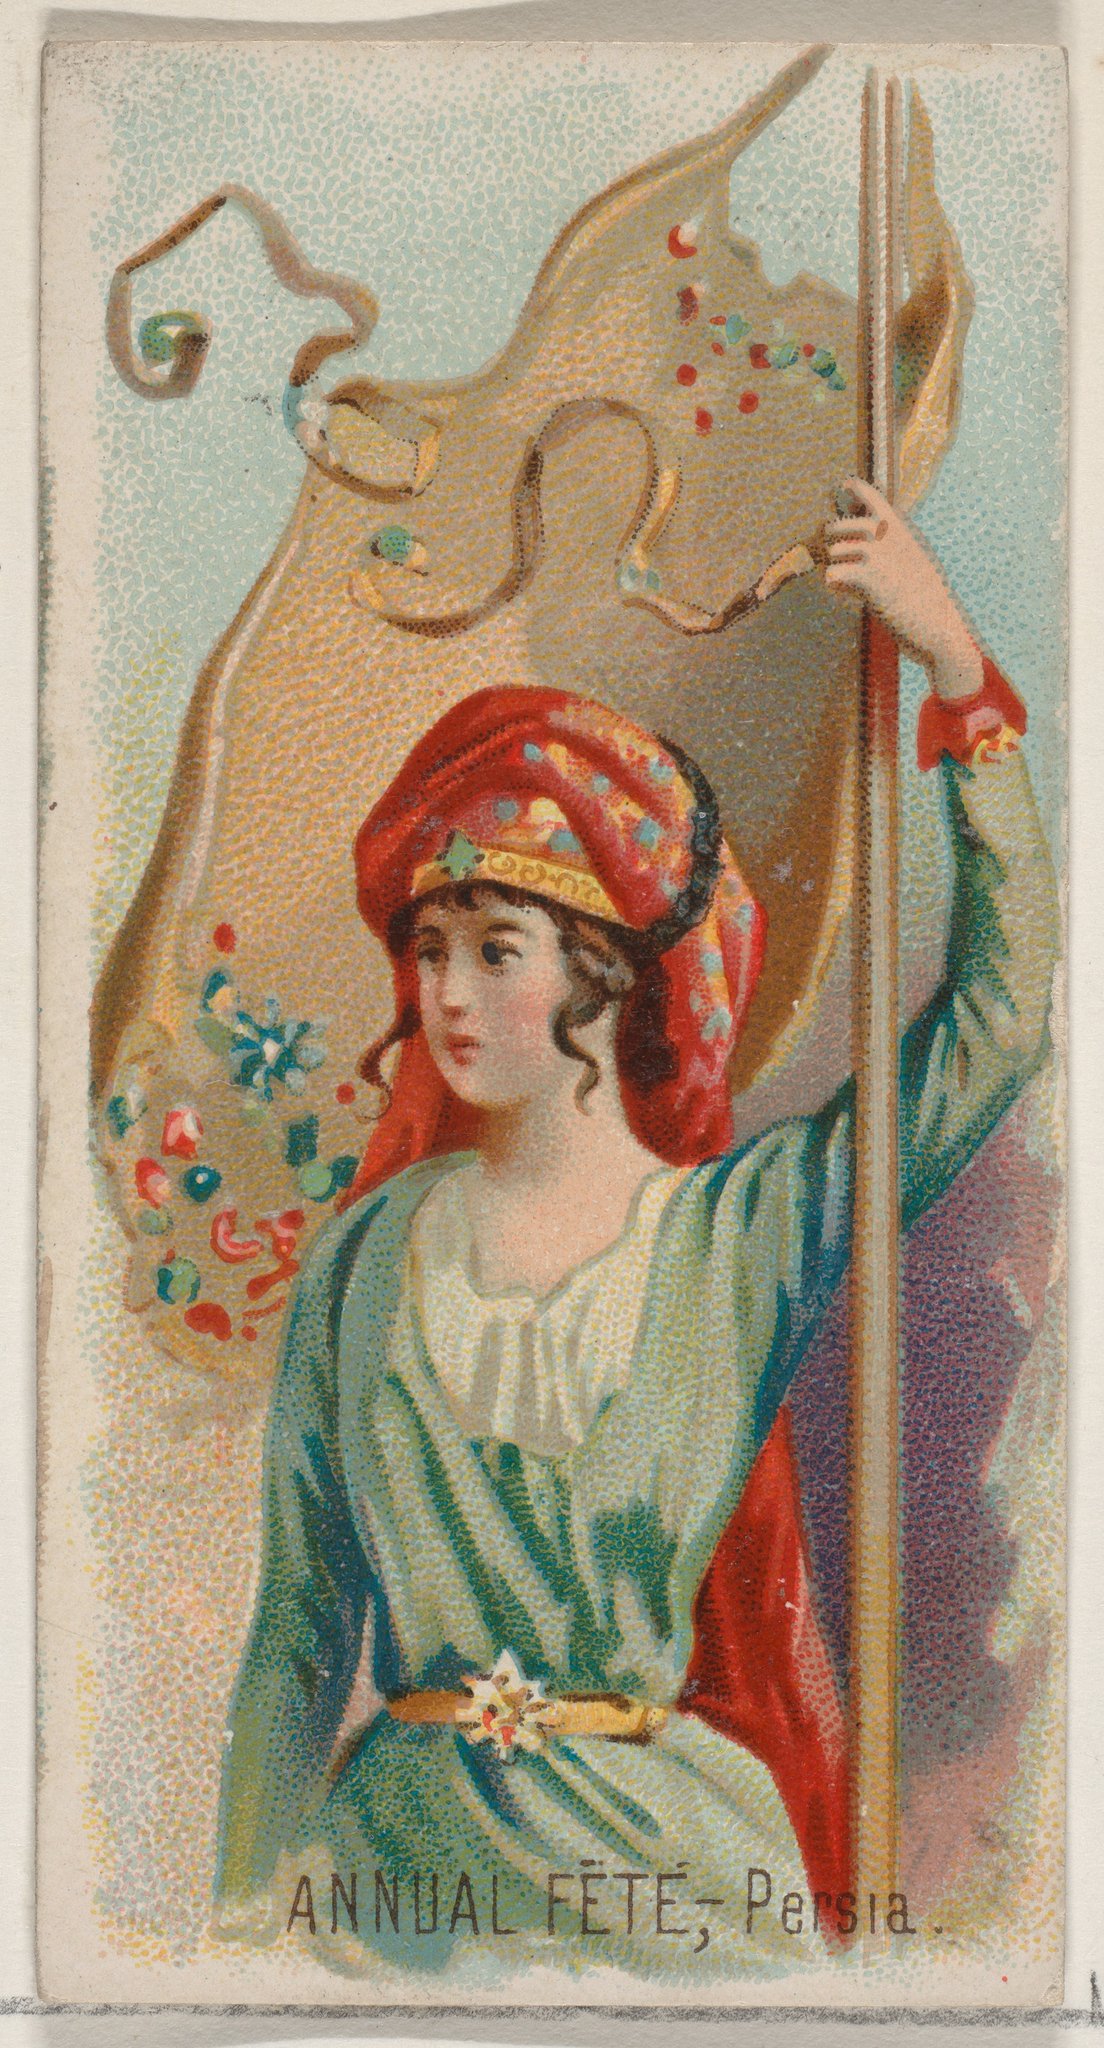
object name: print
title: Annual Fête, Persia, from the Holidays series (N80) for Duke brand cigarettes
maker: w. duke, sons & co.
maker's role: publisher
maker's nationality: american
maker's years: 1870-1920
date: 1890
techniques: color lithograph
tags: women